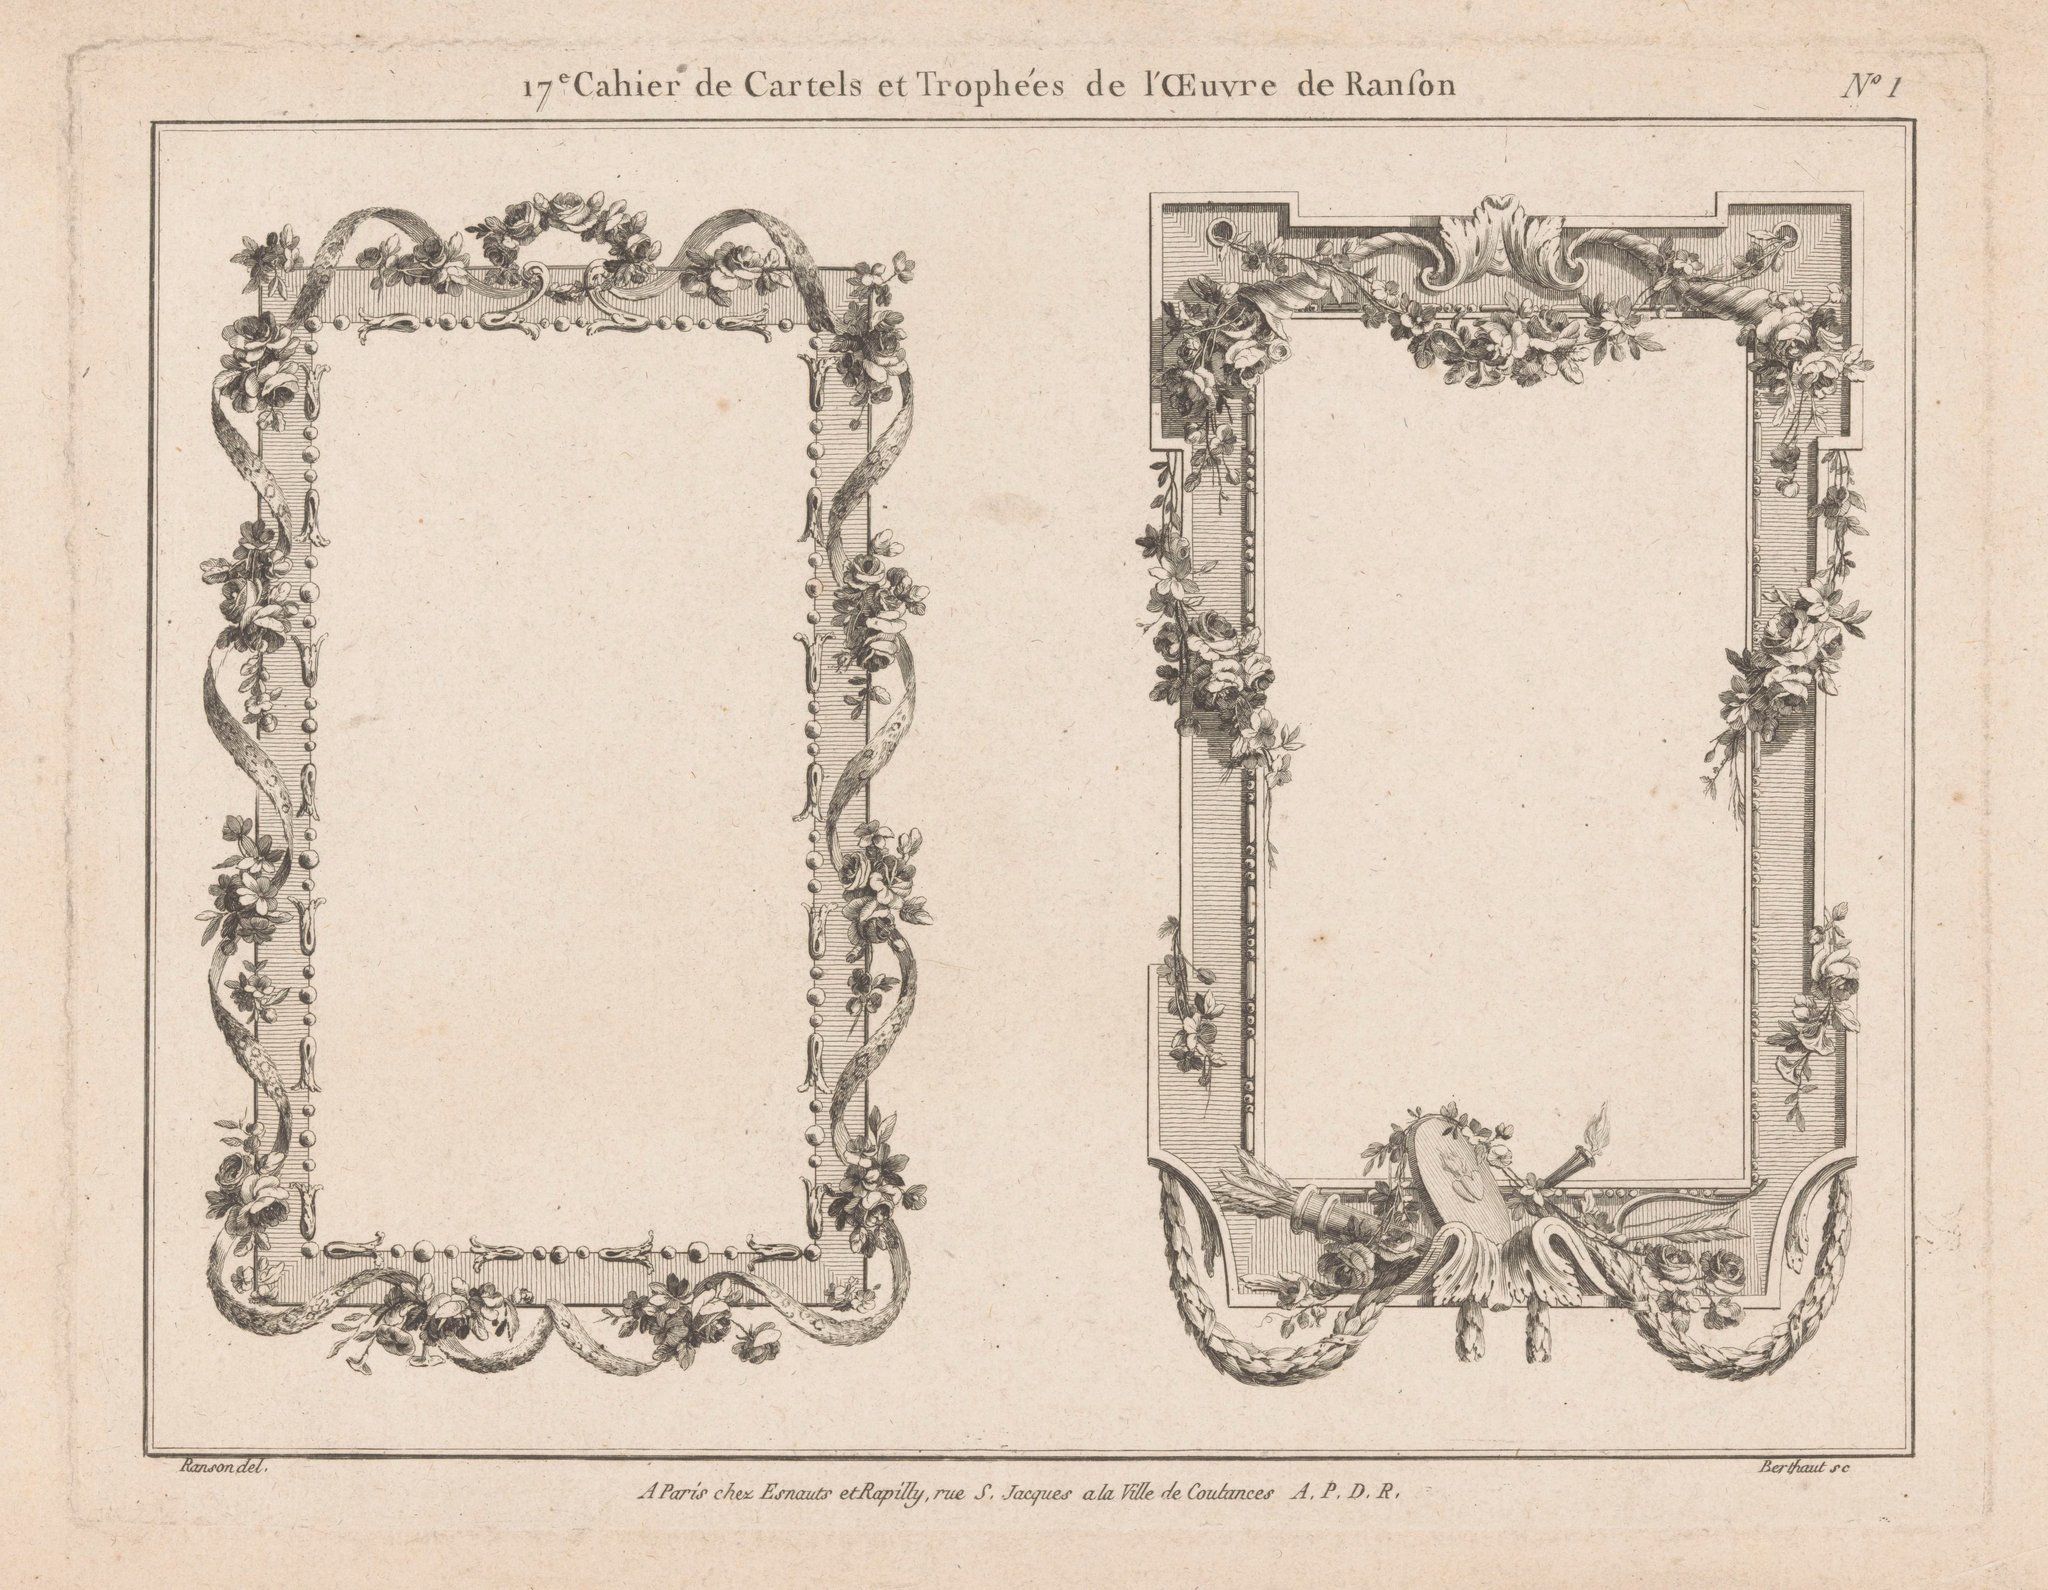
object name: print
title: Omlijstingen met wapens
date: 1778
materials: paper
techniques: etching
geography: paris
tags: ornaments ~ art (+ framing decorations), weapons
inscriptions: collector's mark: Lugt 2228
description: Twee rechthoekige omlijstingen met bloemen. Rechts met guirlandes en een schild met harten, een pijlenkoker, een fakkel en pijl en boog aan de onderzijde.